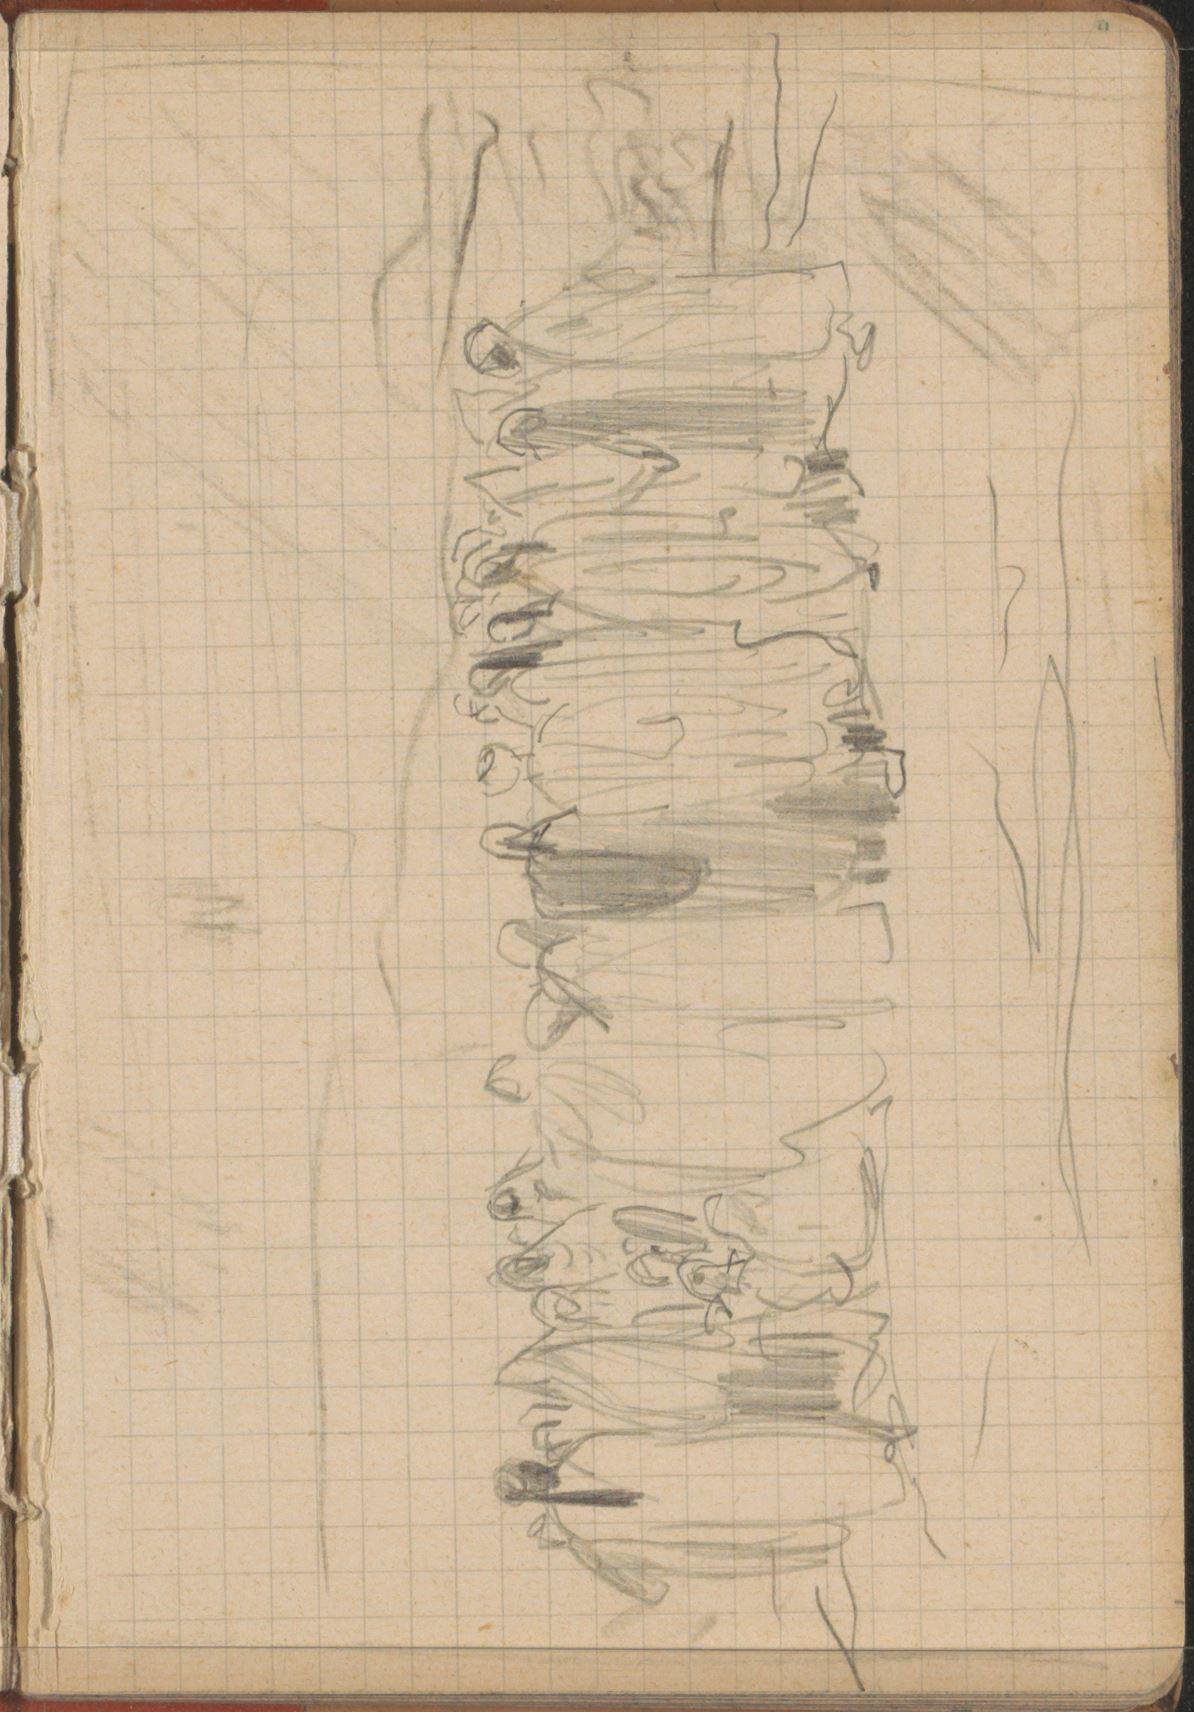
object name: sketchbook leaf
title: Groep toeschouwers, op de rug gezien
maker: marius bauer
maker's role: draughtsman, print maker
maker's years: 1867-1932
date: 1909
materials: pencil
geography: tunis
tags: standing figure, sitting figure, the audience ~ art performance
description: Pagina 21 uit een schetsboek met 67 bladen.